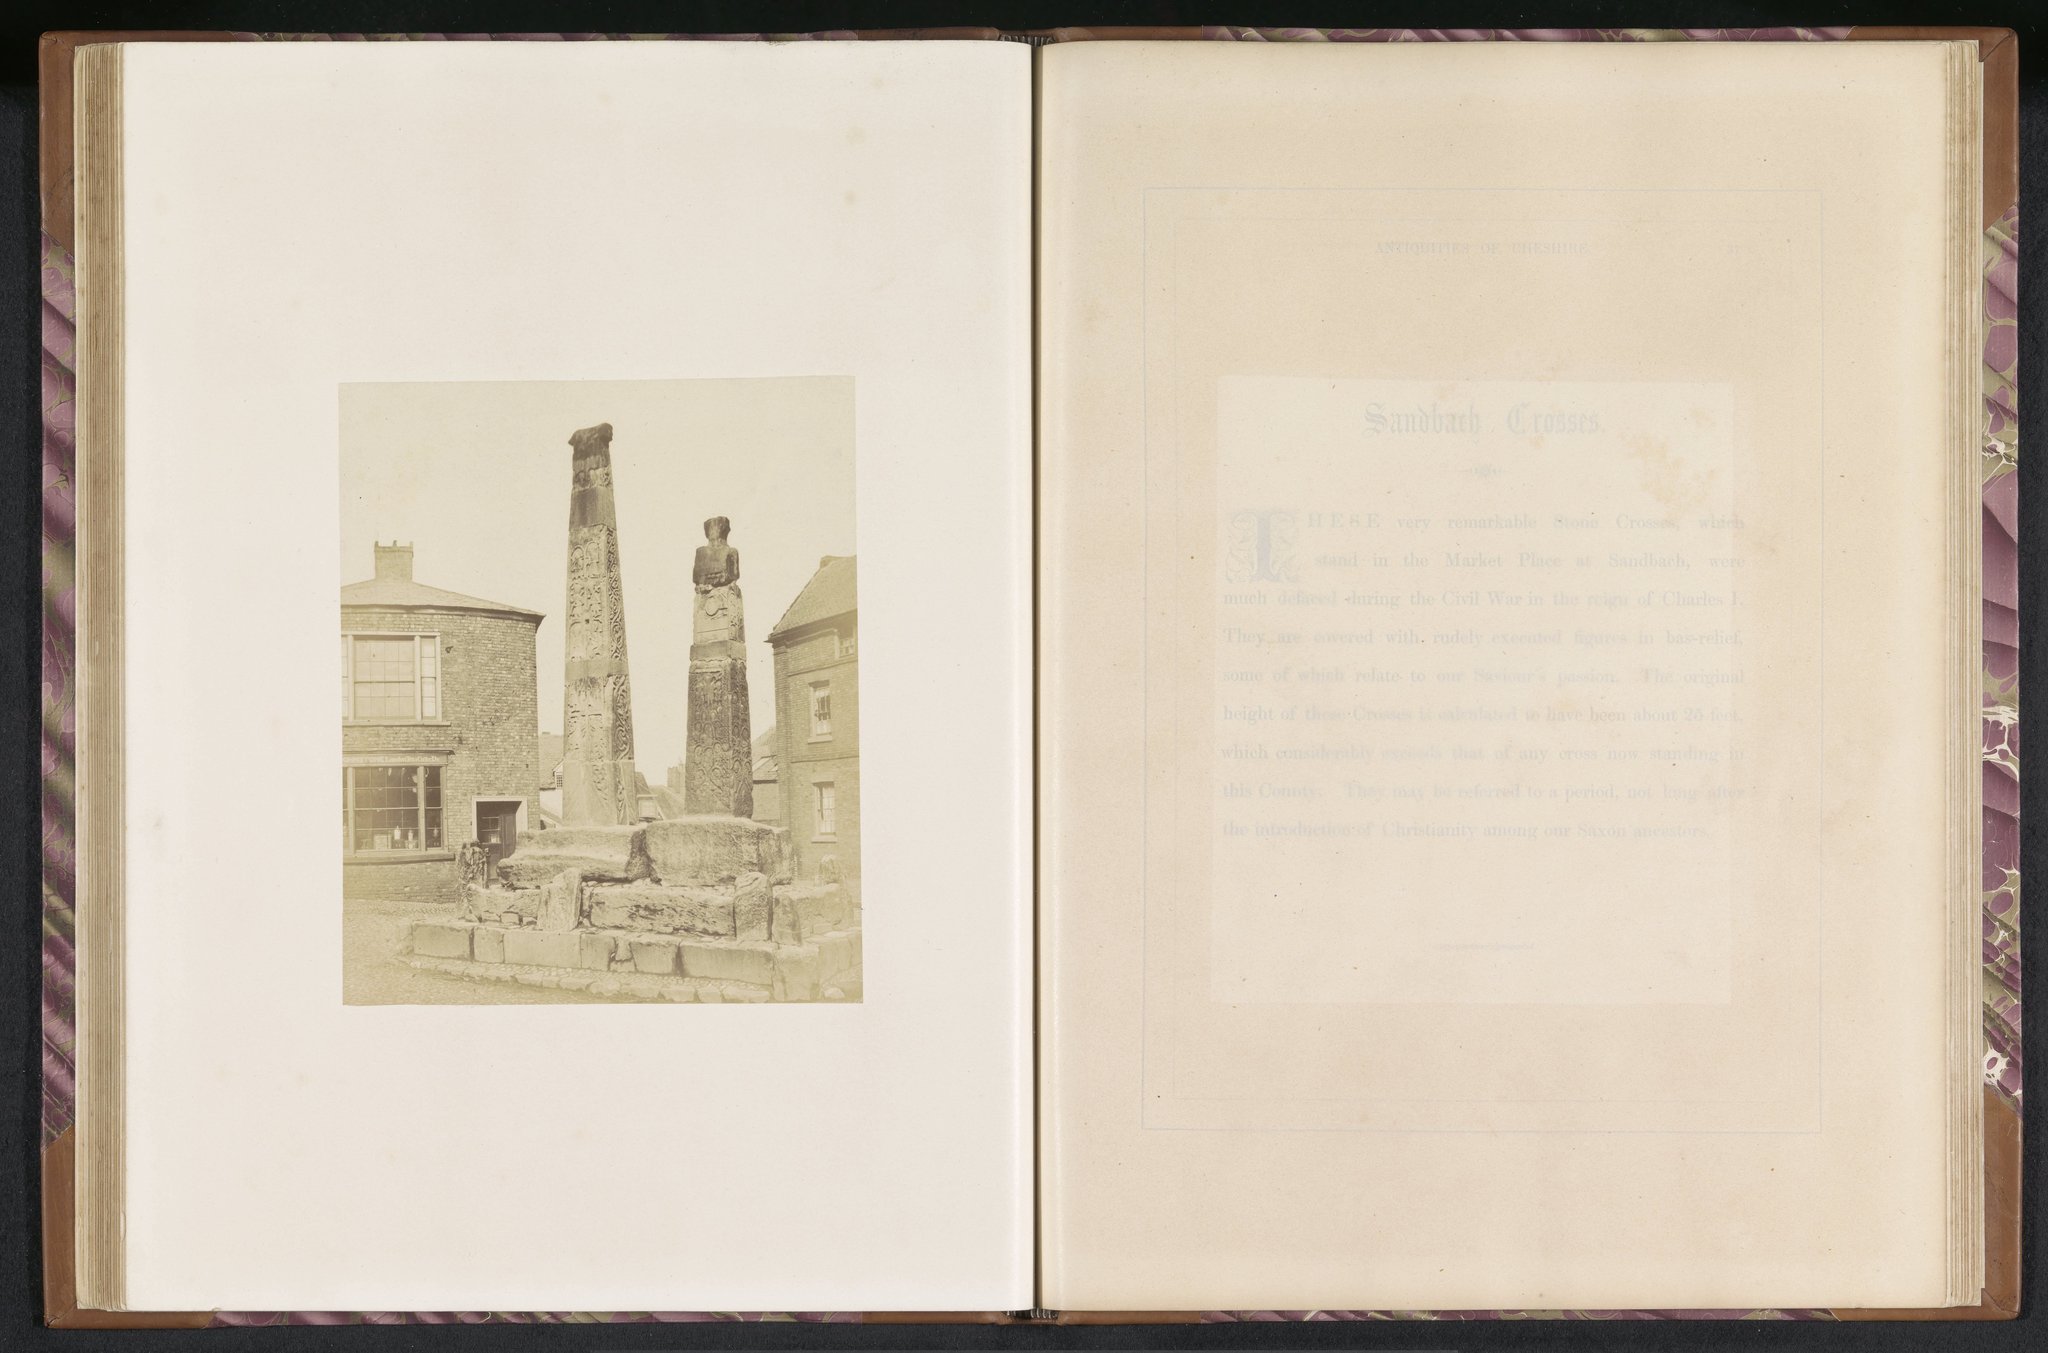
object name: page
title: Sandbach Crosses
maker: william bryans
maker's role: fotograaf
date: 1850-1858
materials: photographic support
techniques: albumen print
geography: sandbach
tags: monument, statue